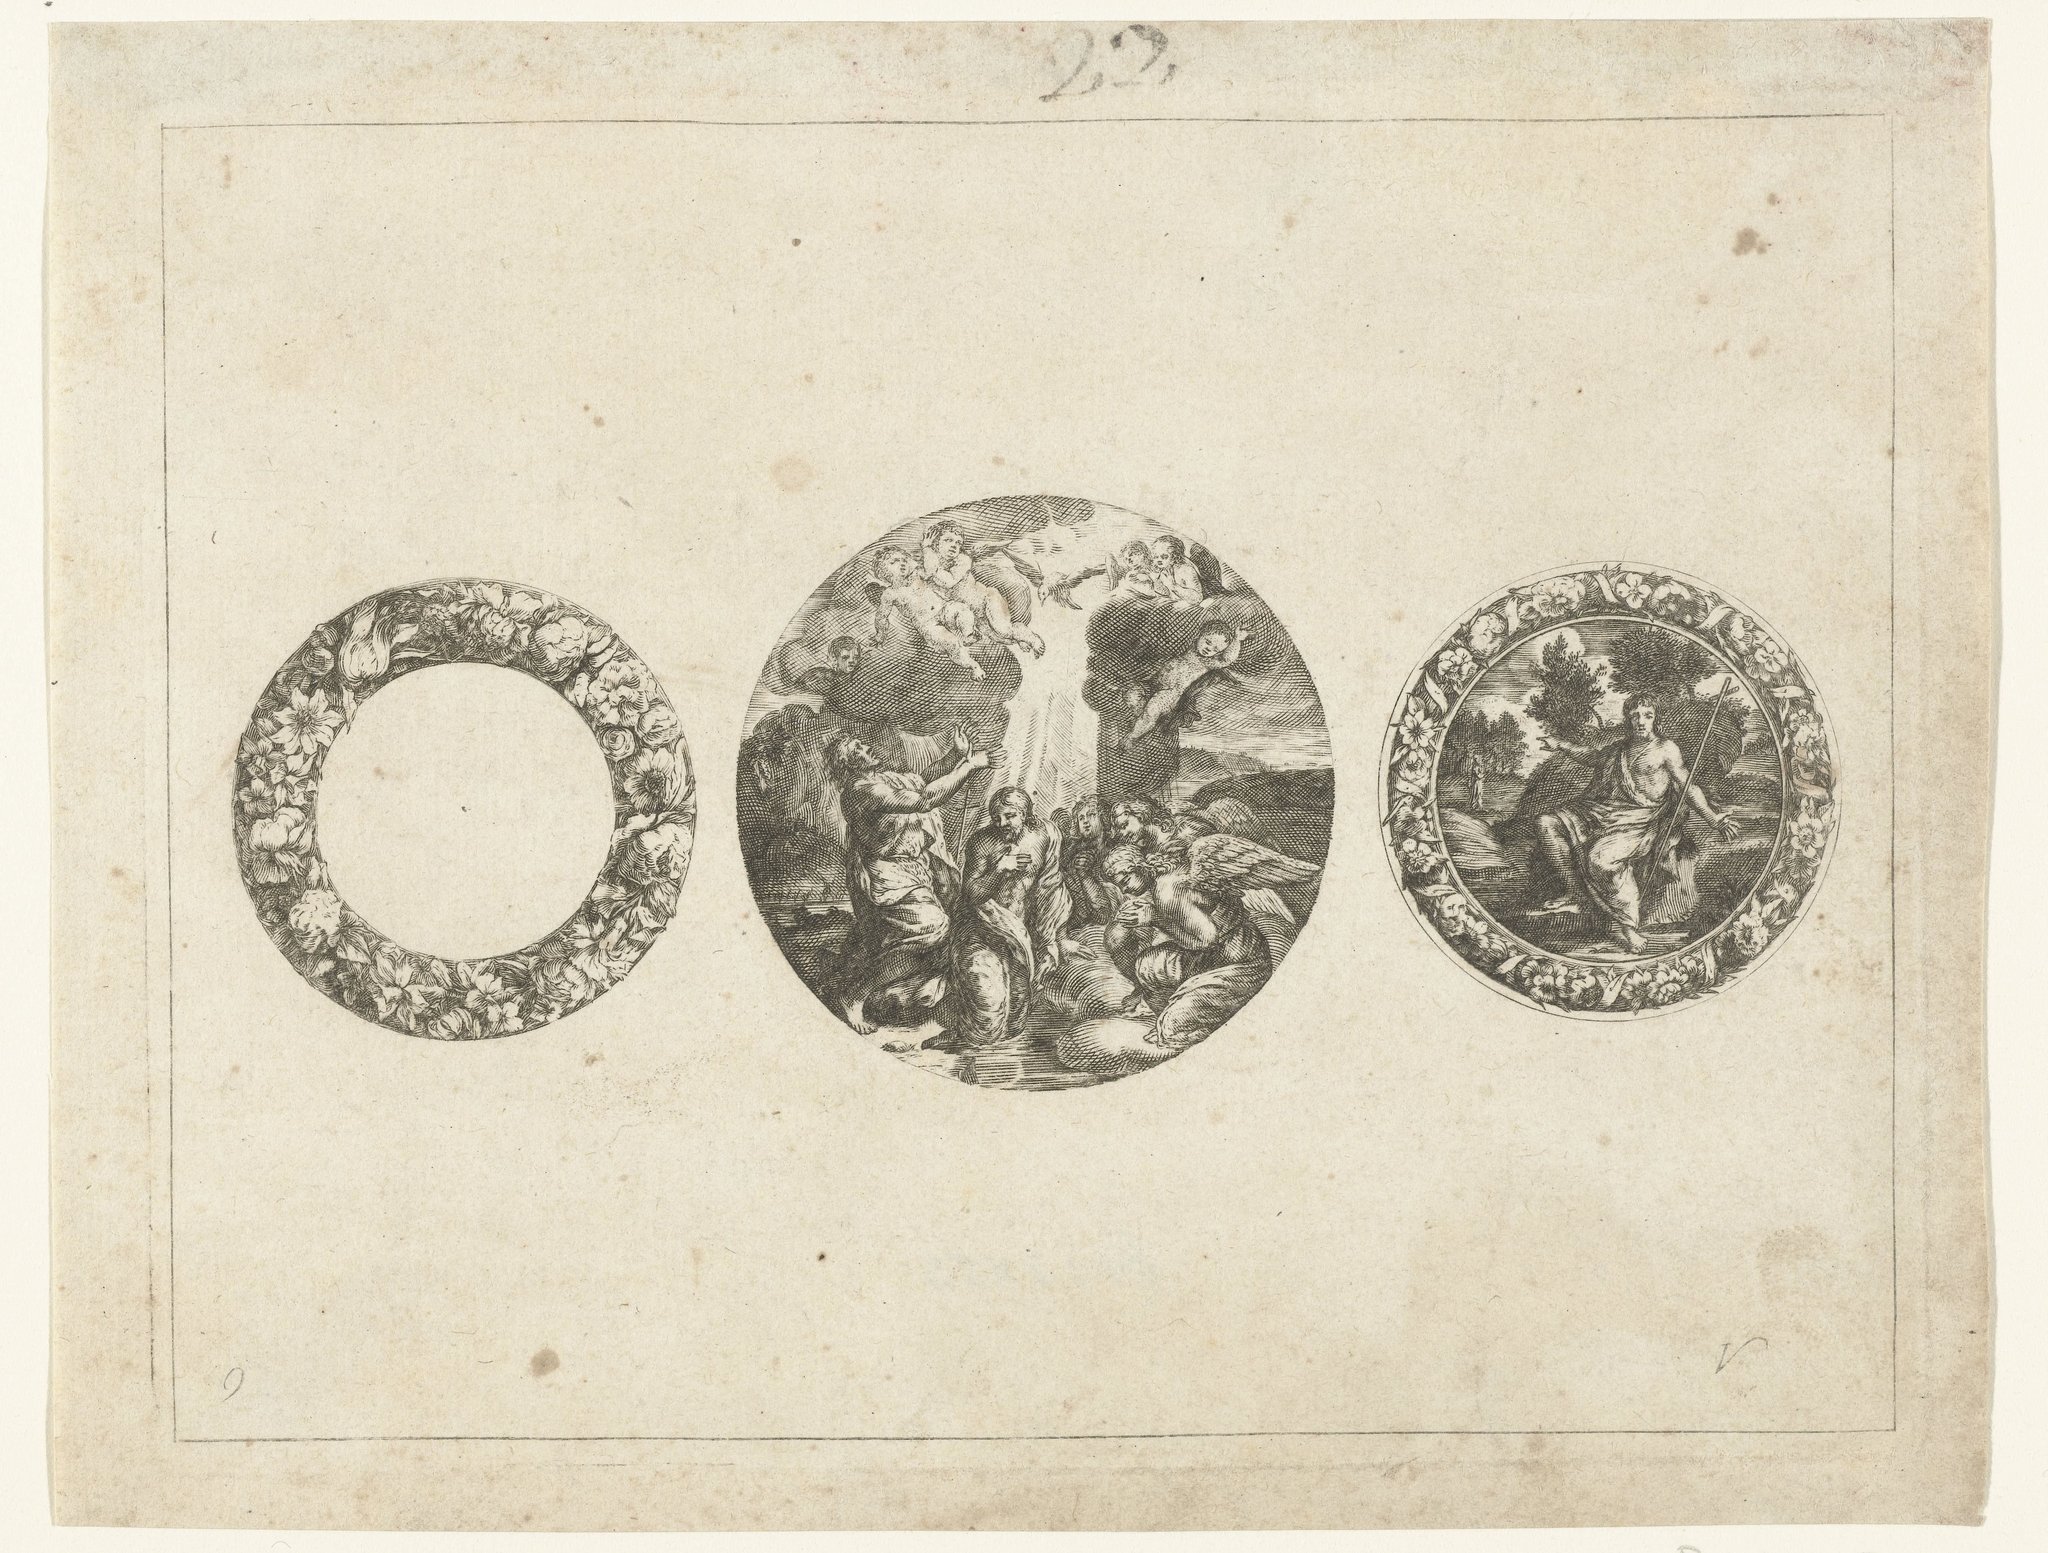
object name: print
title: Edelsmidsontwerpen voor horlogekasten: deksels en zijkanten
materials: paper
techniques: engraving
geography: france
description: In het midden een horlogekast met de Doop van Christus, rechts een medaillon met Johannes de Doper omringd door een rand van bloemen. Eerste editie, tweede druk.